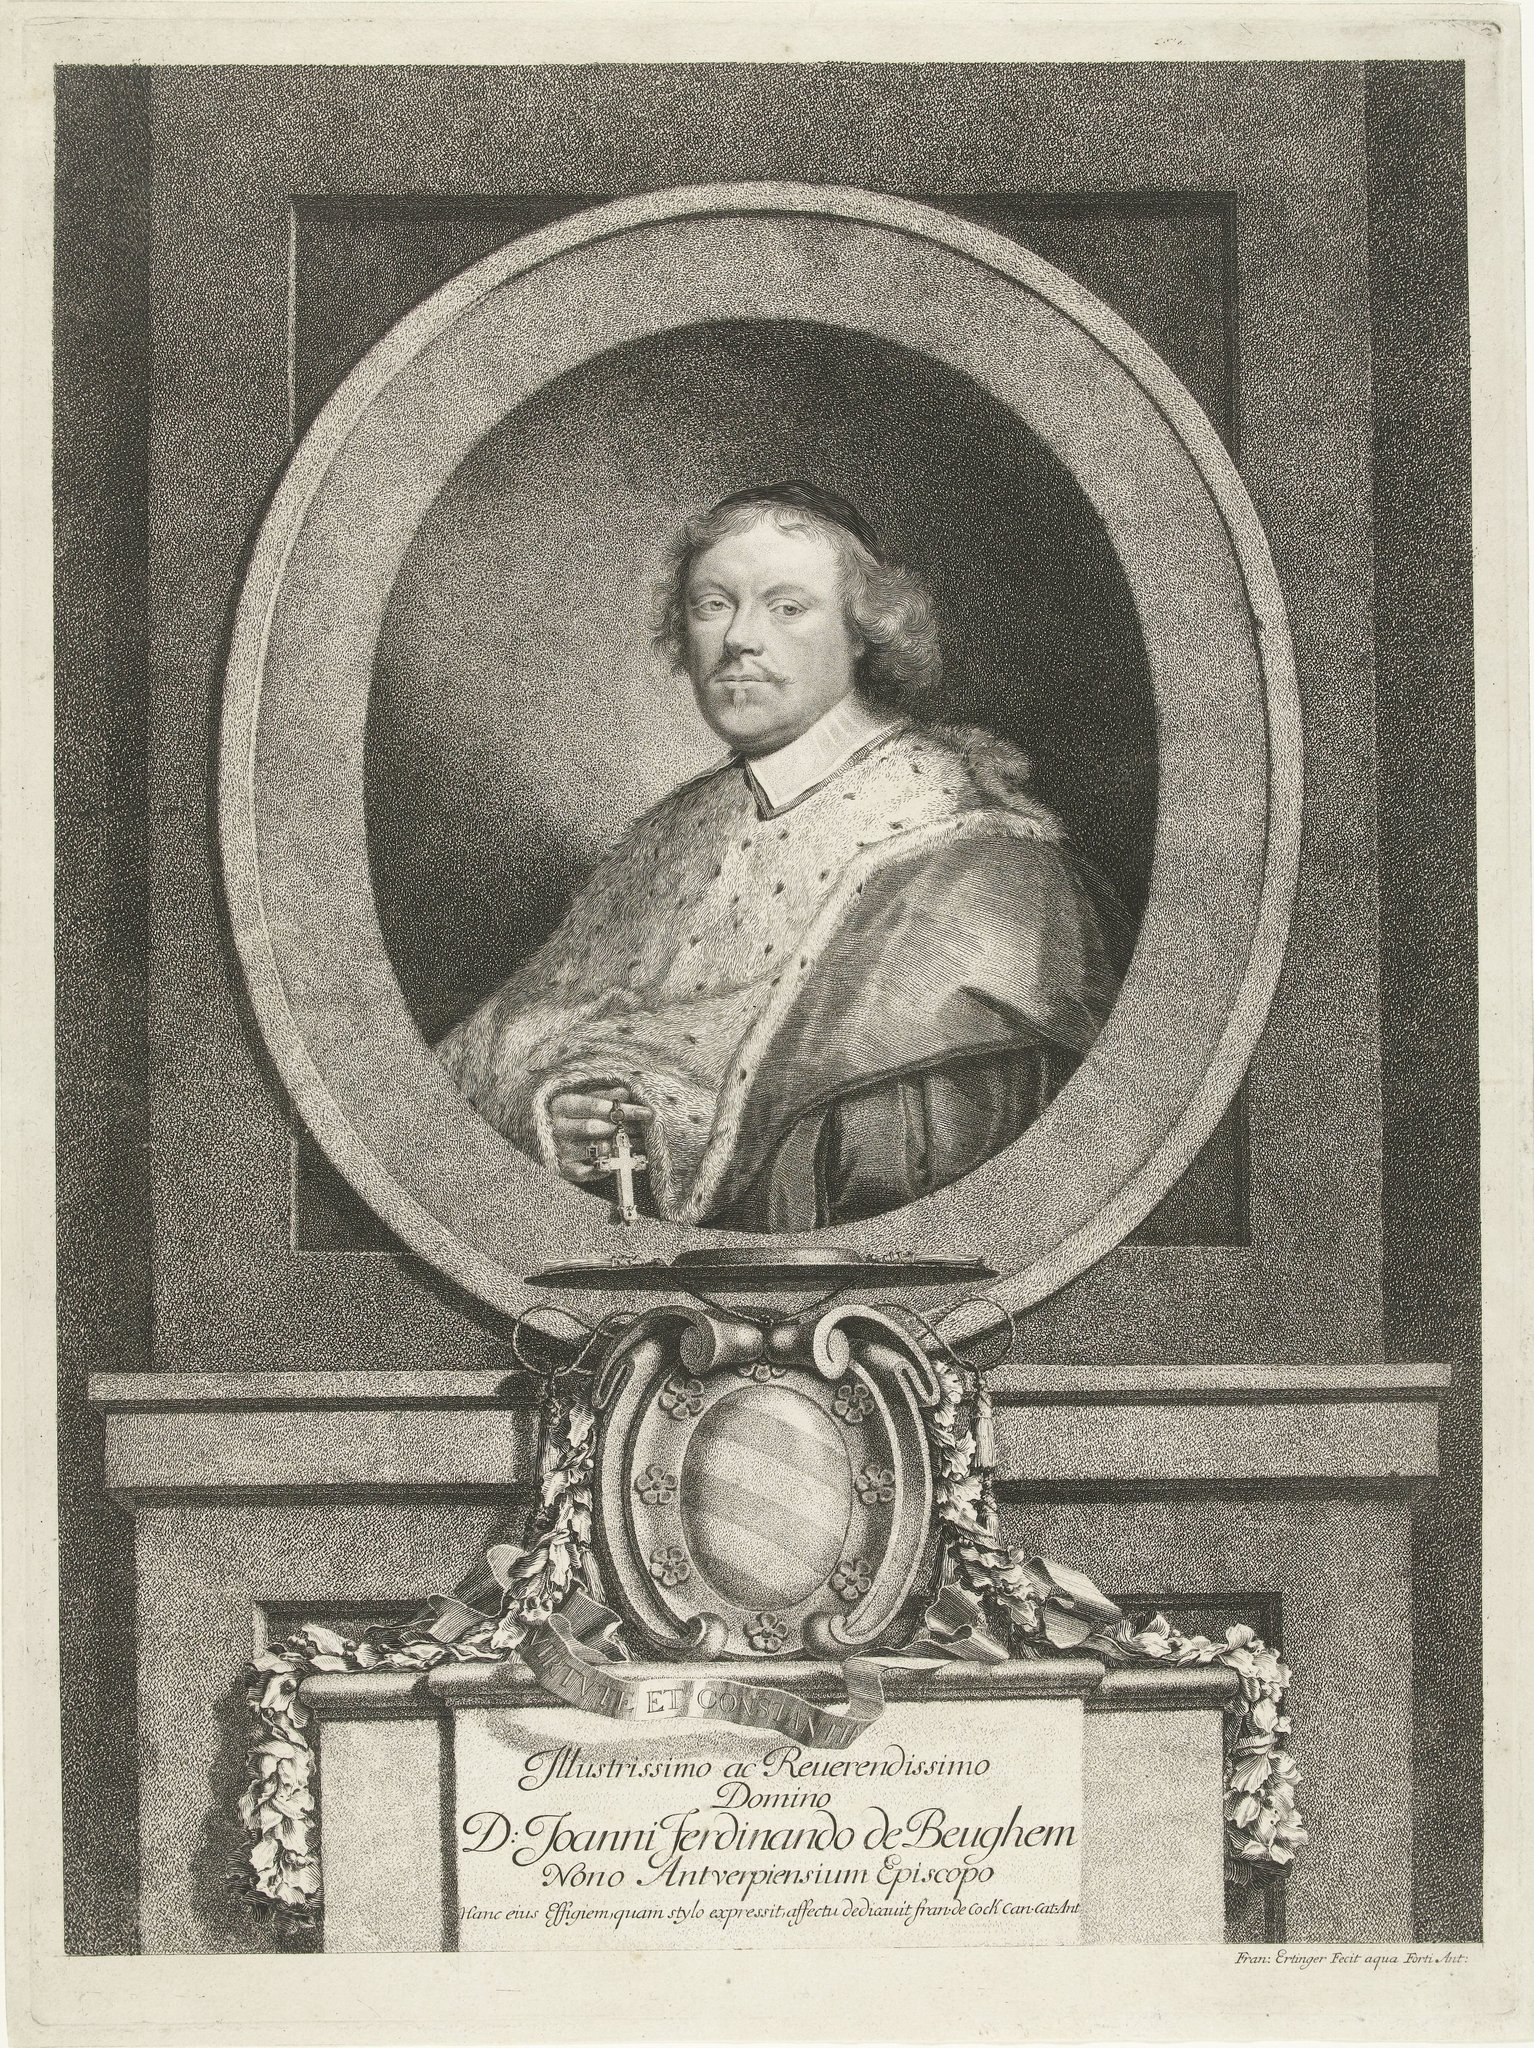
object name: print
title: Portret van Johan Ferdinand de Beughem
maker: franz ertinger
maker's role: print maker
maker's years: 1640-1710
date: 1650-1710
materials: paper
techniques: engraving, etching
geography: paris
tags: bisschop, johan ferdinand beughem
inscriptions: collector's mark: Lugt 2228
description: Portret van Johan Ferdinand de Beughem, bisschop van Antwerpen. Afgebeeld in ovale omlijsting, met kruis in zijn hand. Onder de lijst een console met bisschopswapen en vijf regels Latijnse tekst.